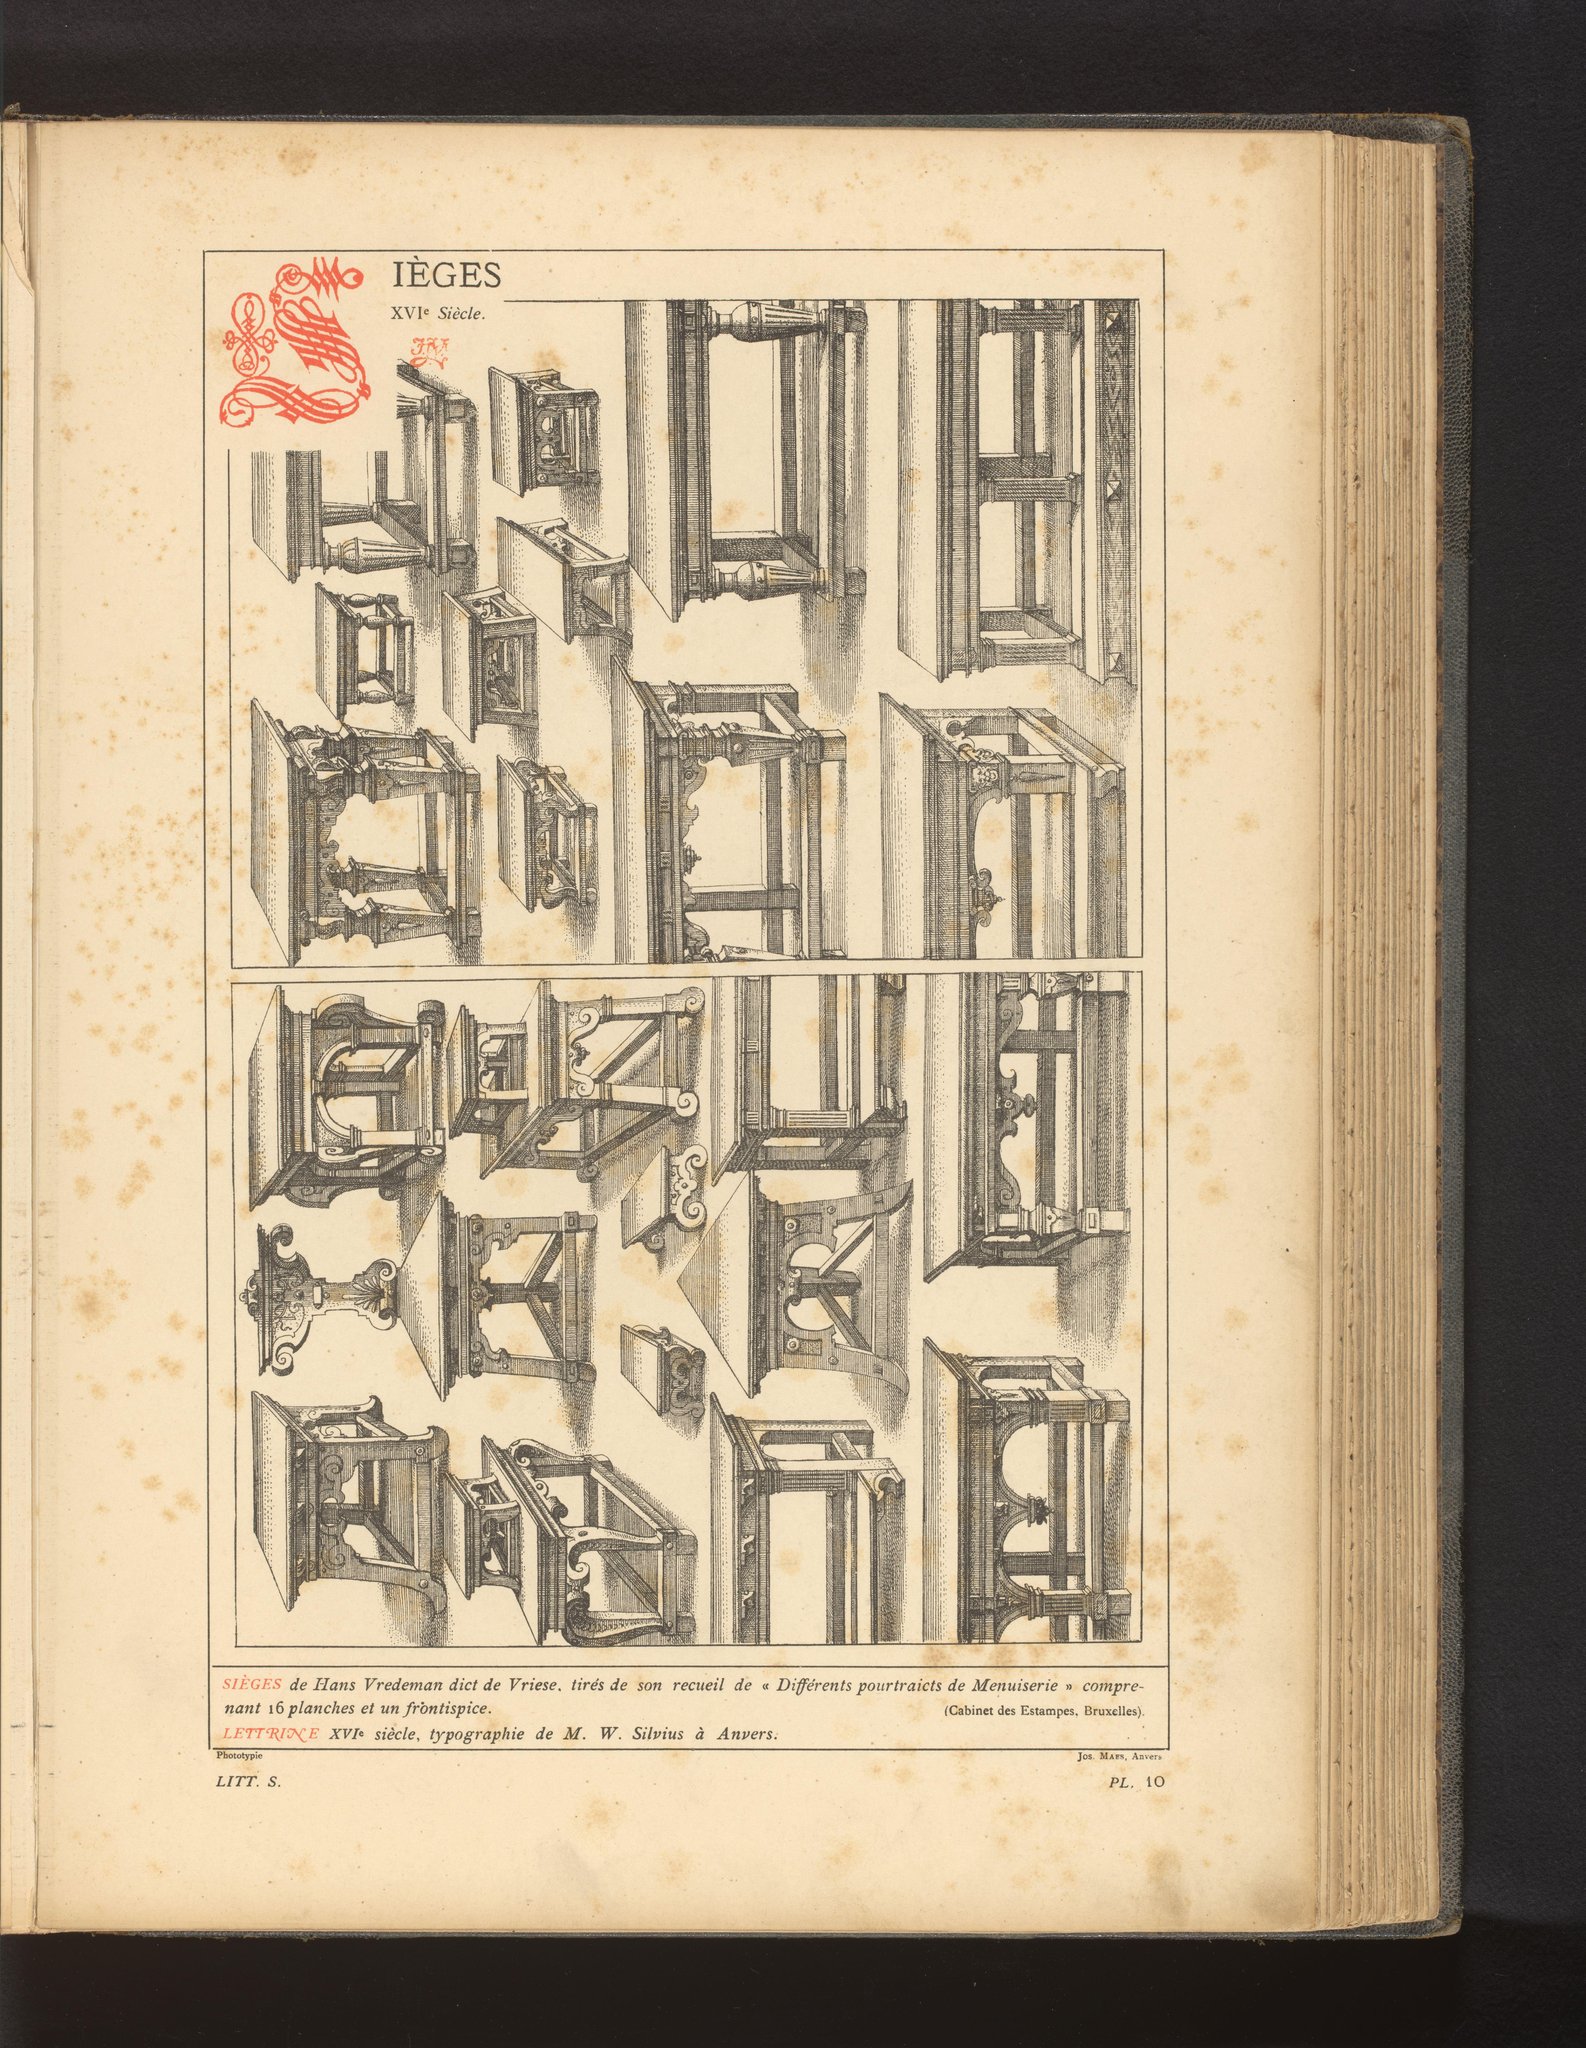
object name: reproduction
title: Sièges, XVIe Siècle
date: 1876-1881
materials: paper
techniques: photolithography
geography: amsterdam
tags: seating furniture, table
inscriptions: inscription: ‘LITT. S. - PL. 10.’, inscription: ‘SIÈGES de Hans Vredeman de Vries (...)’, monogram: ‘JJvY’